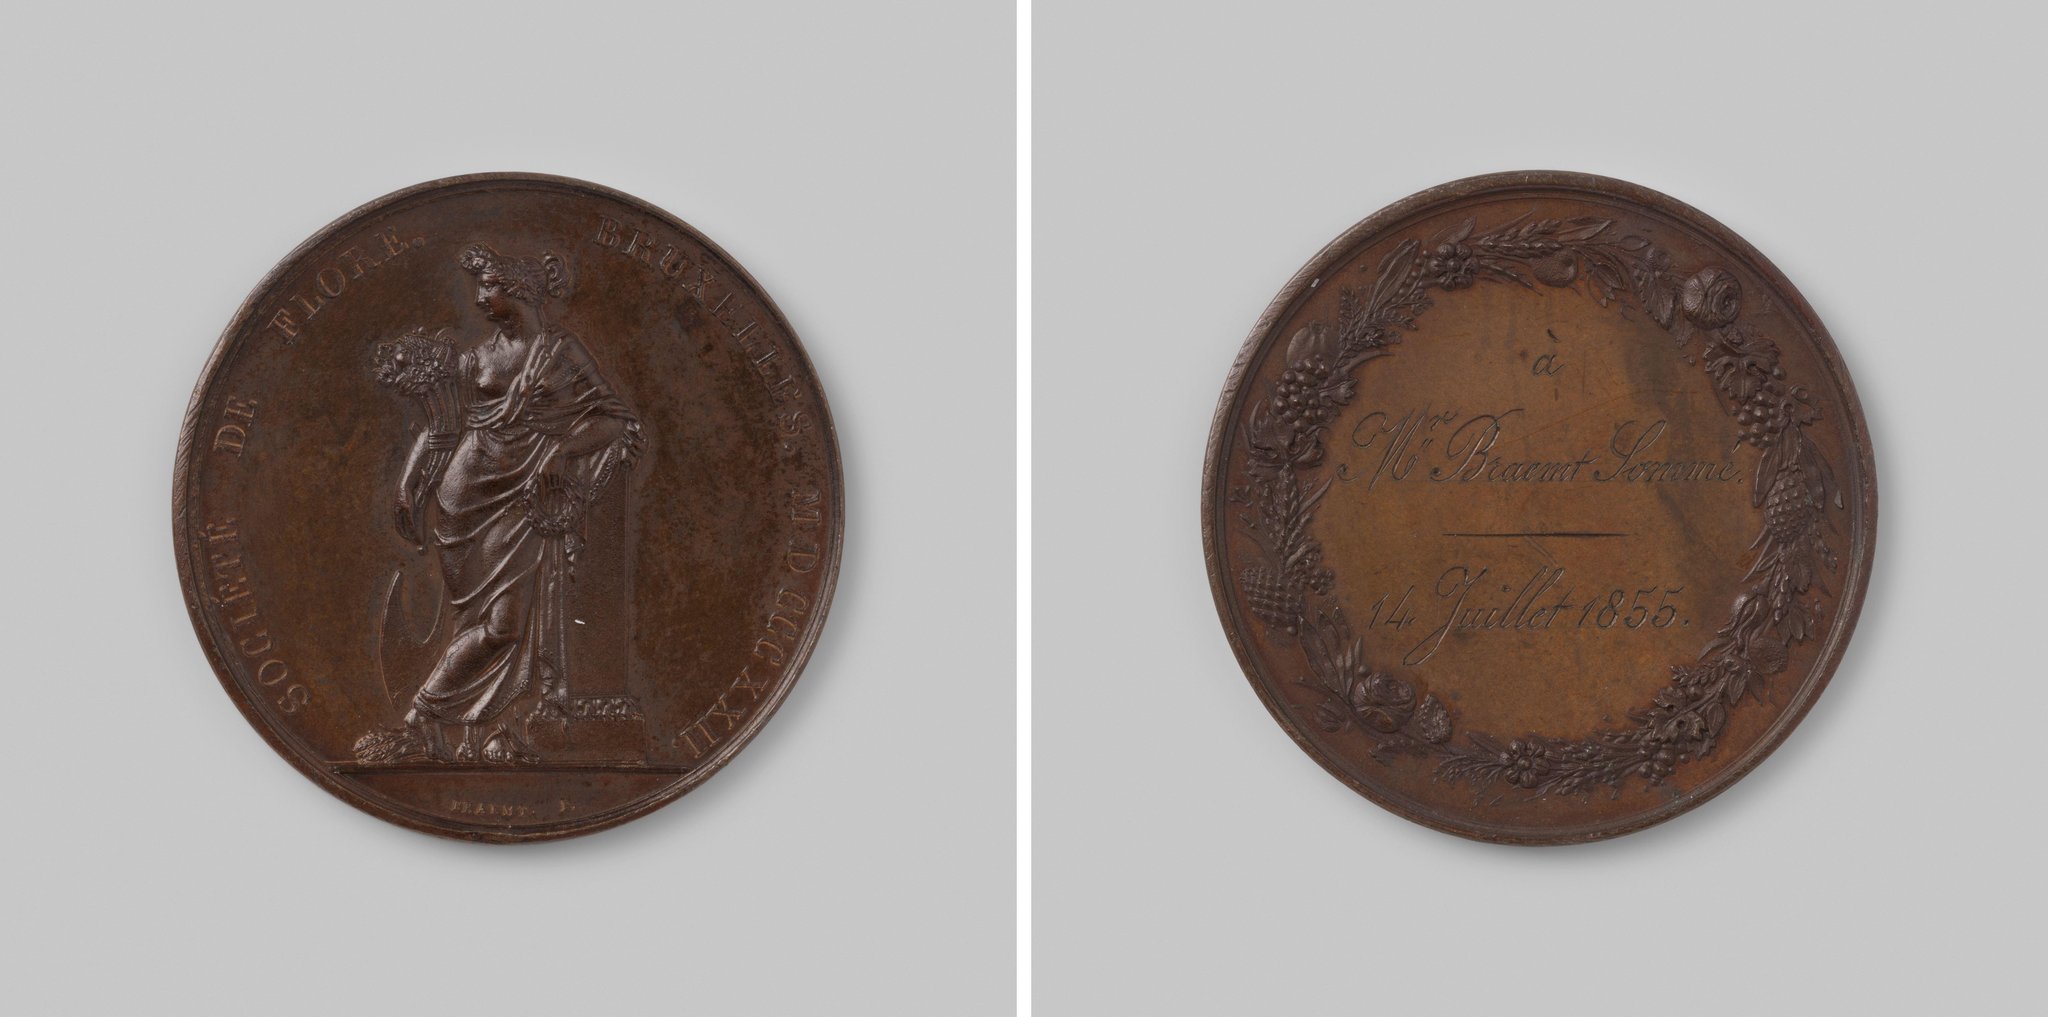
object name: medal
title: Societe de Flore te Brussel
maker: joseph pierre braemt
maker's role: print maker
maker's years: 1796-1864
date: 1822-1855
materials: bronze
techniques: engraving, striking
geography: brussels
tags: ghent, brussels, print maker, joseph pierre braemt